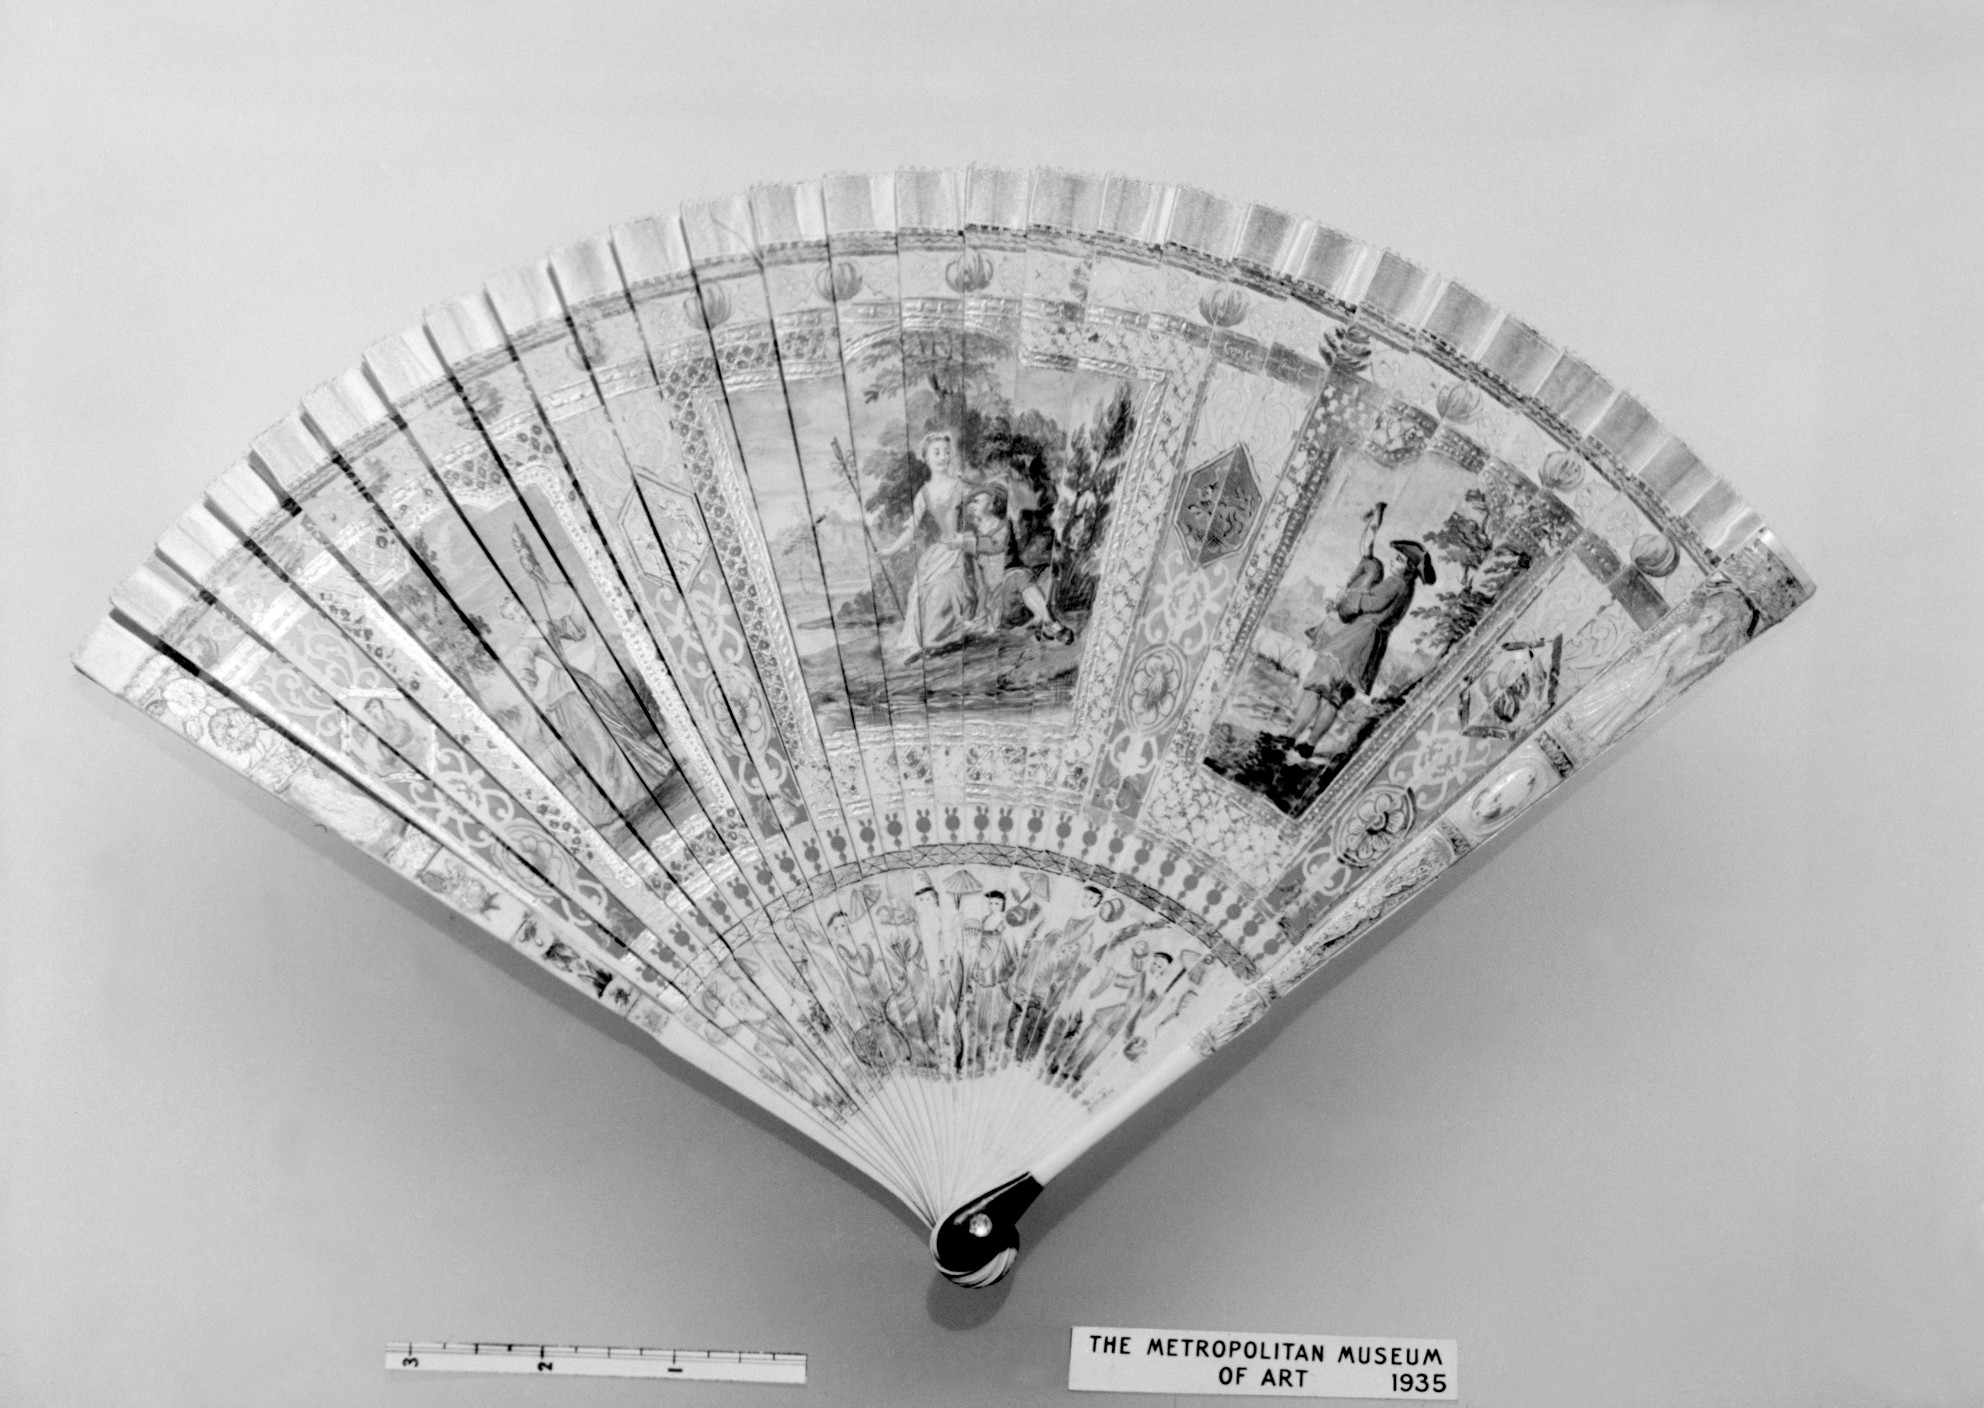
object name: fan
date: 1701-1750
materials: ivory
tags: girls,men